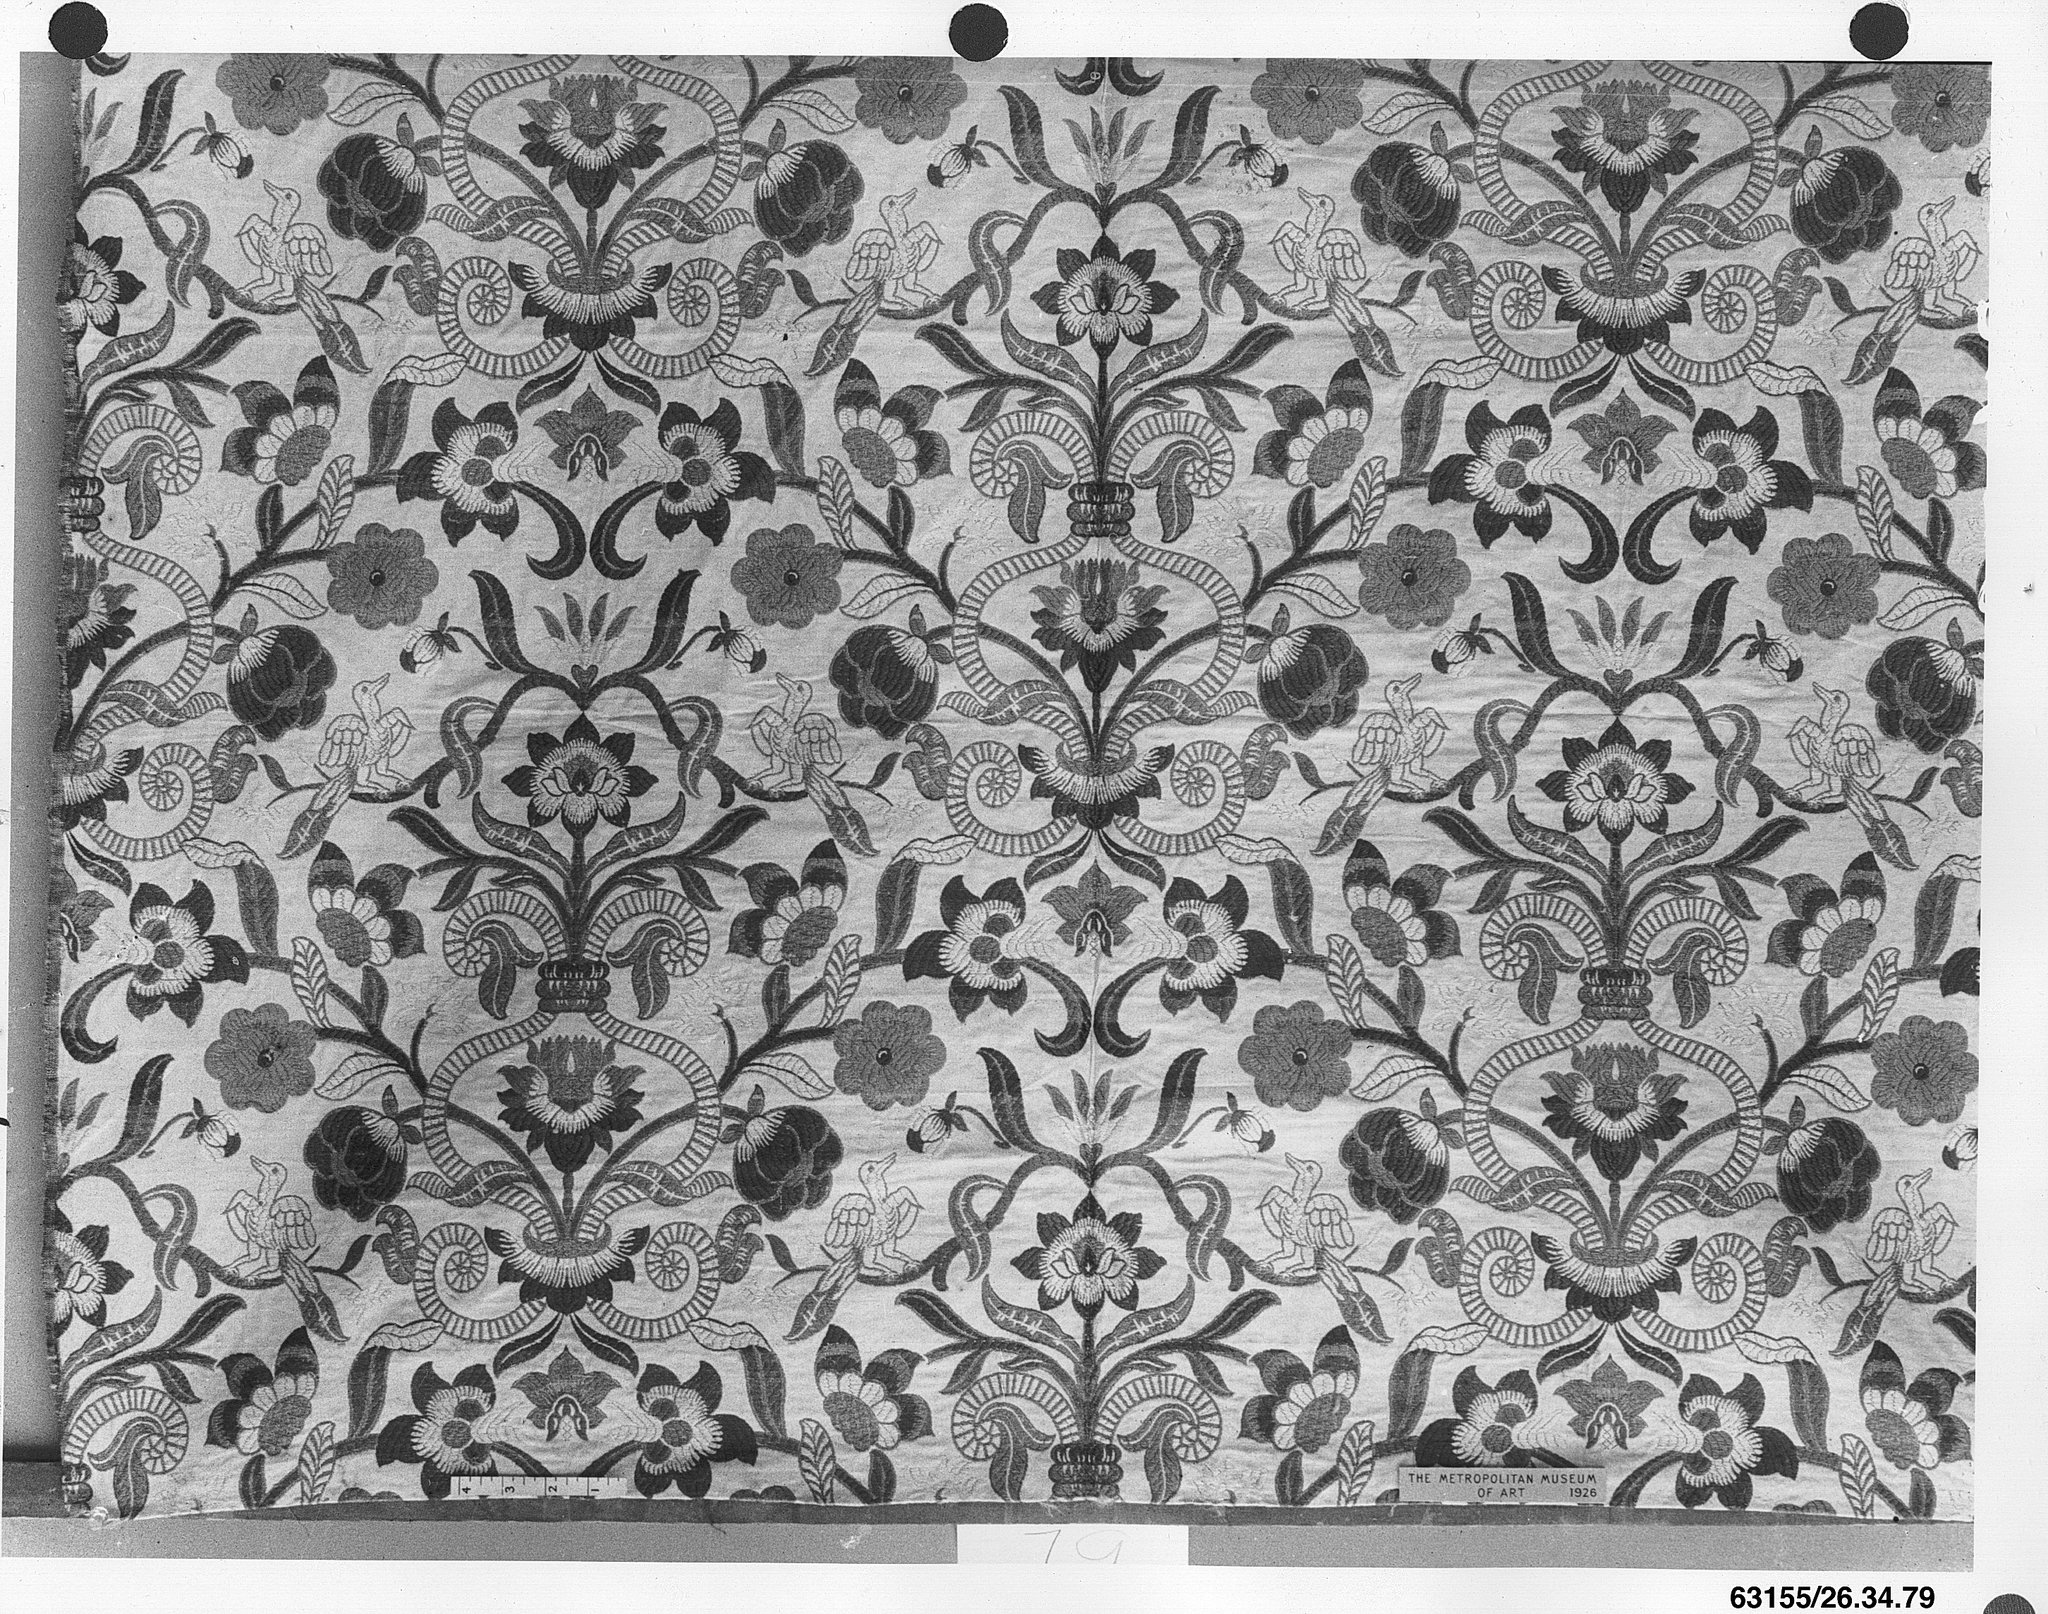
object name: piece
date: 1801-1900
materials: metal thread, silk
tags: birds,flowers,leaves